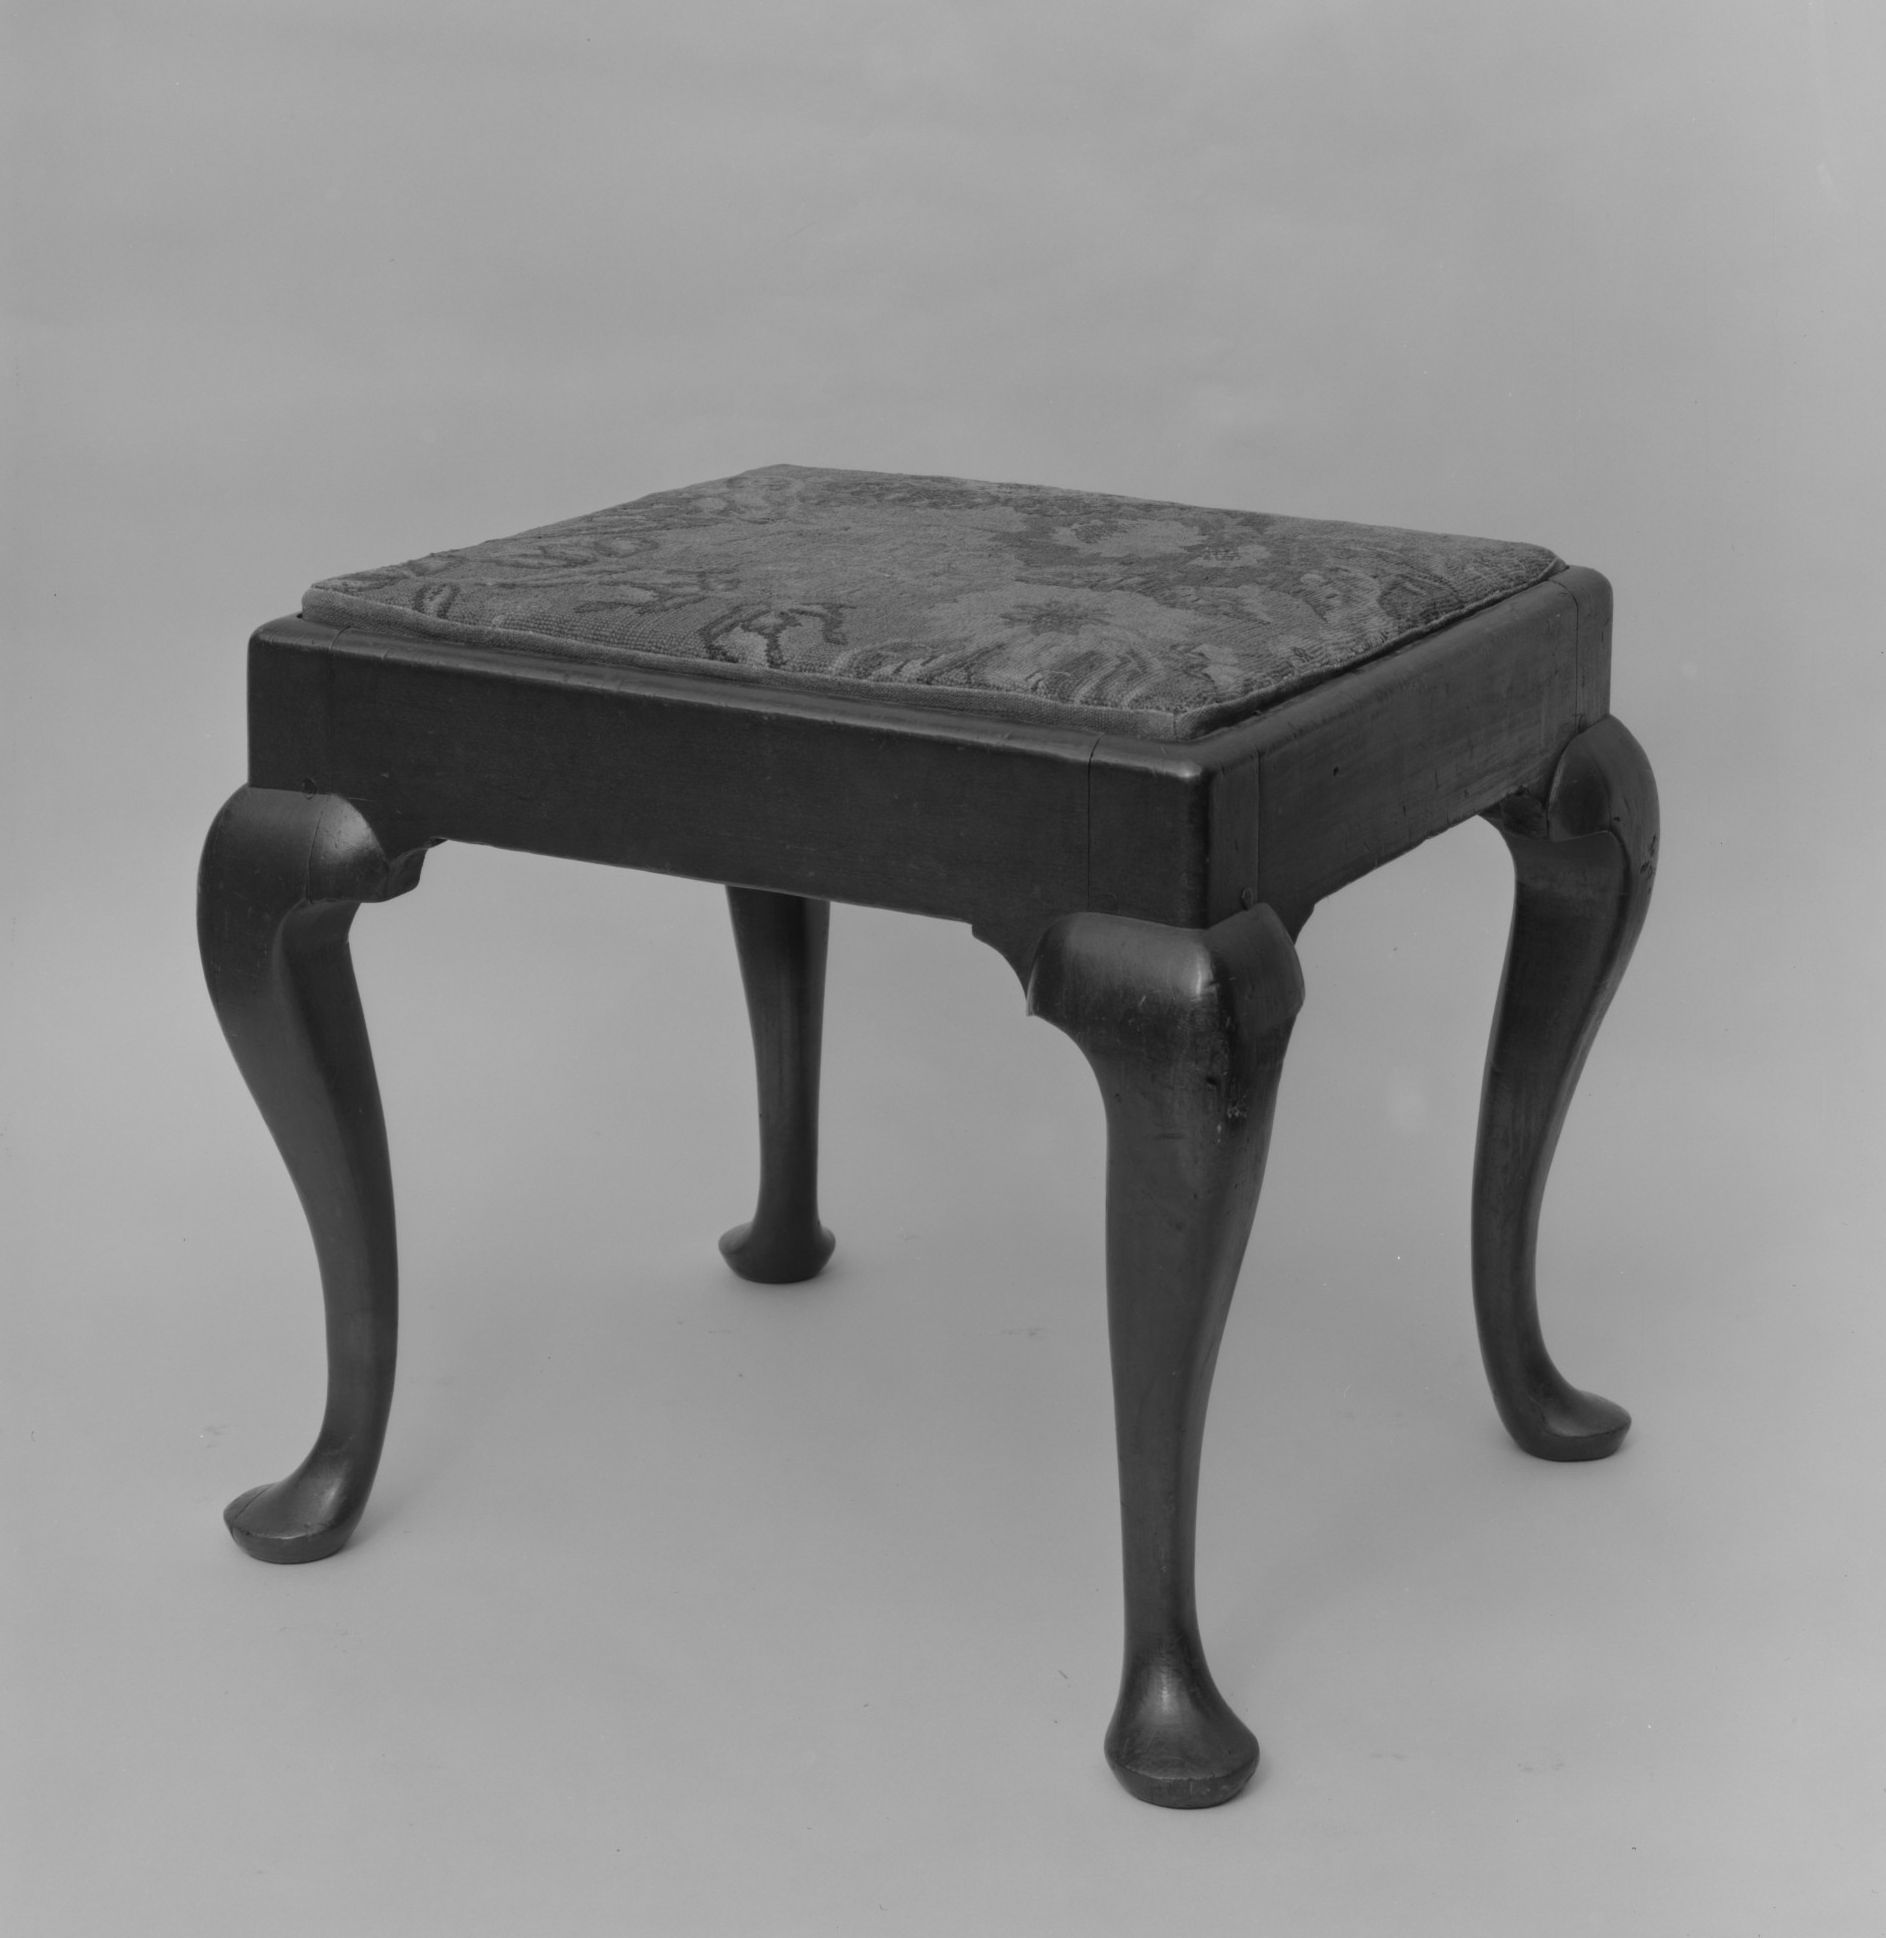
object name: footstool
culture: american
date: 1730-1760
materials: wood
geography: united states